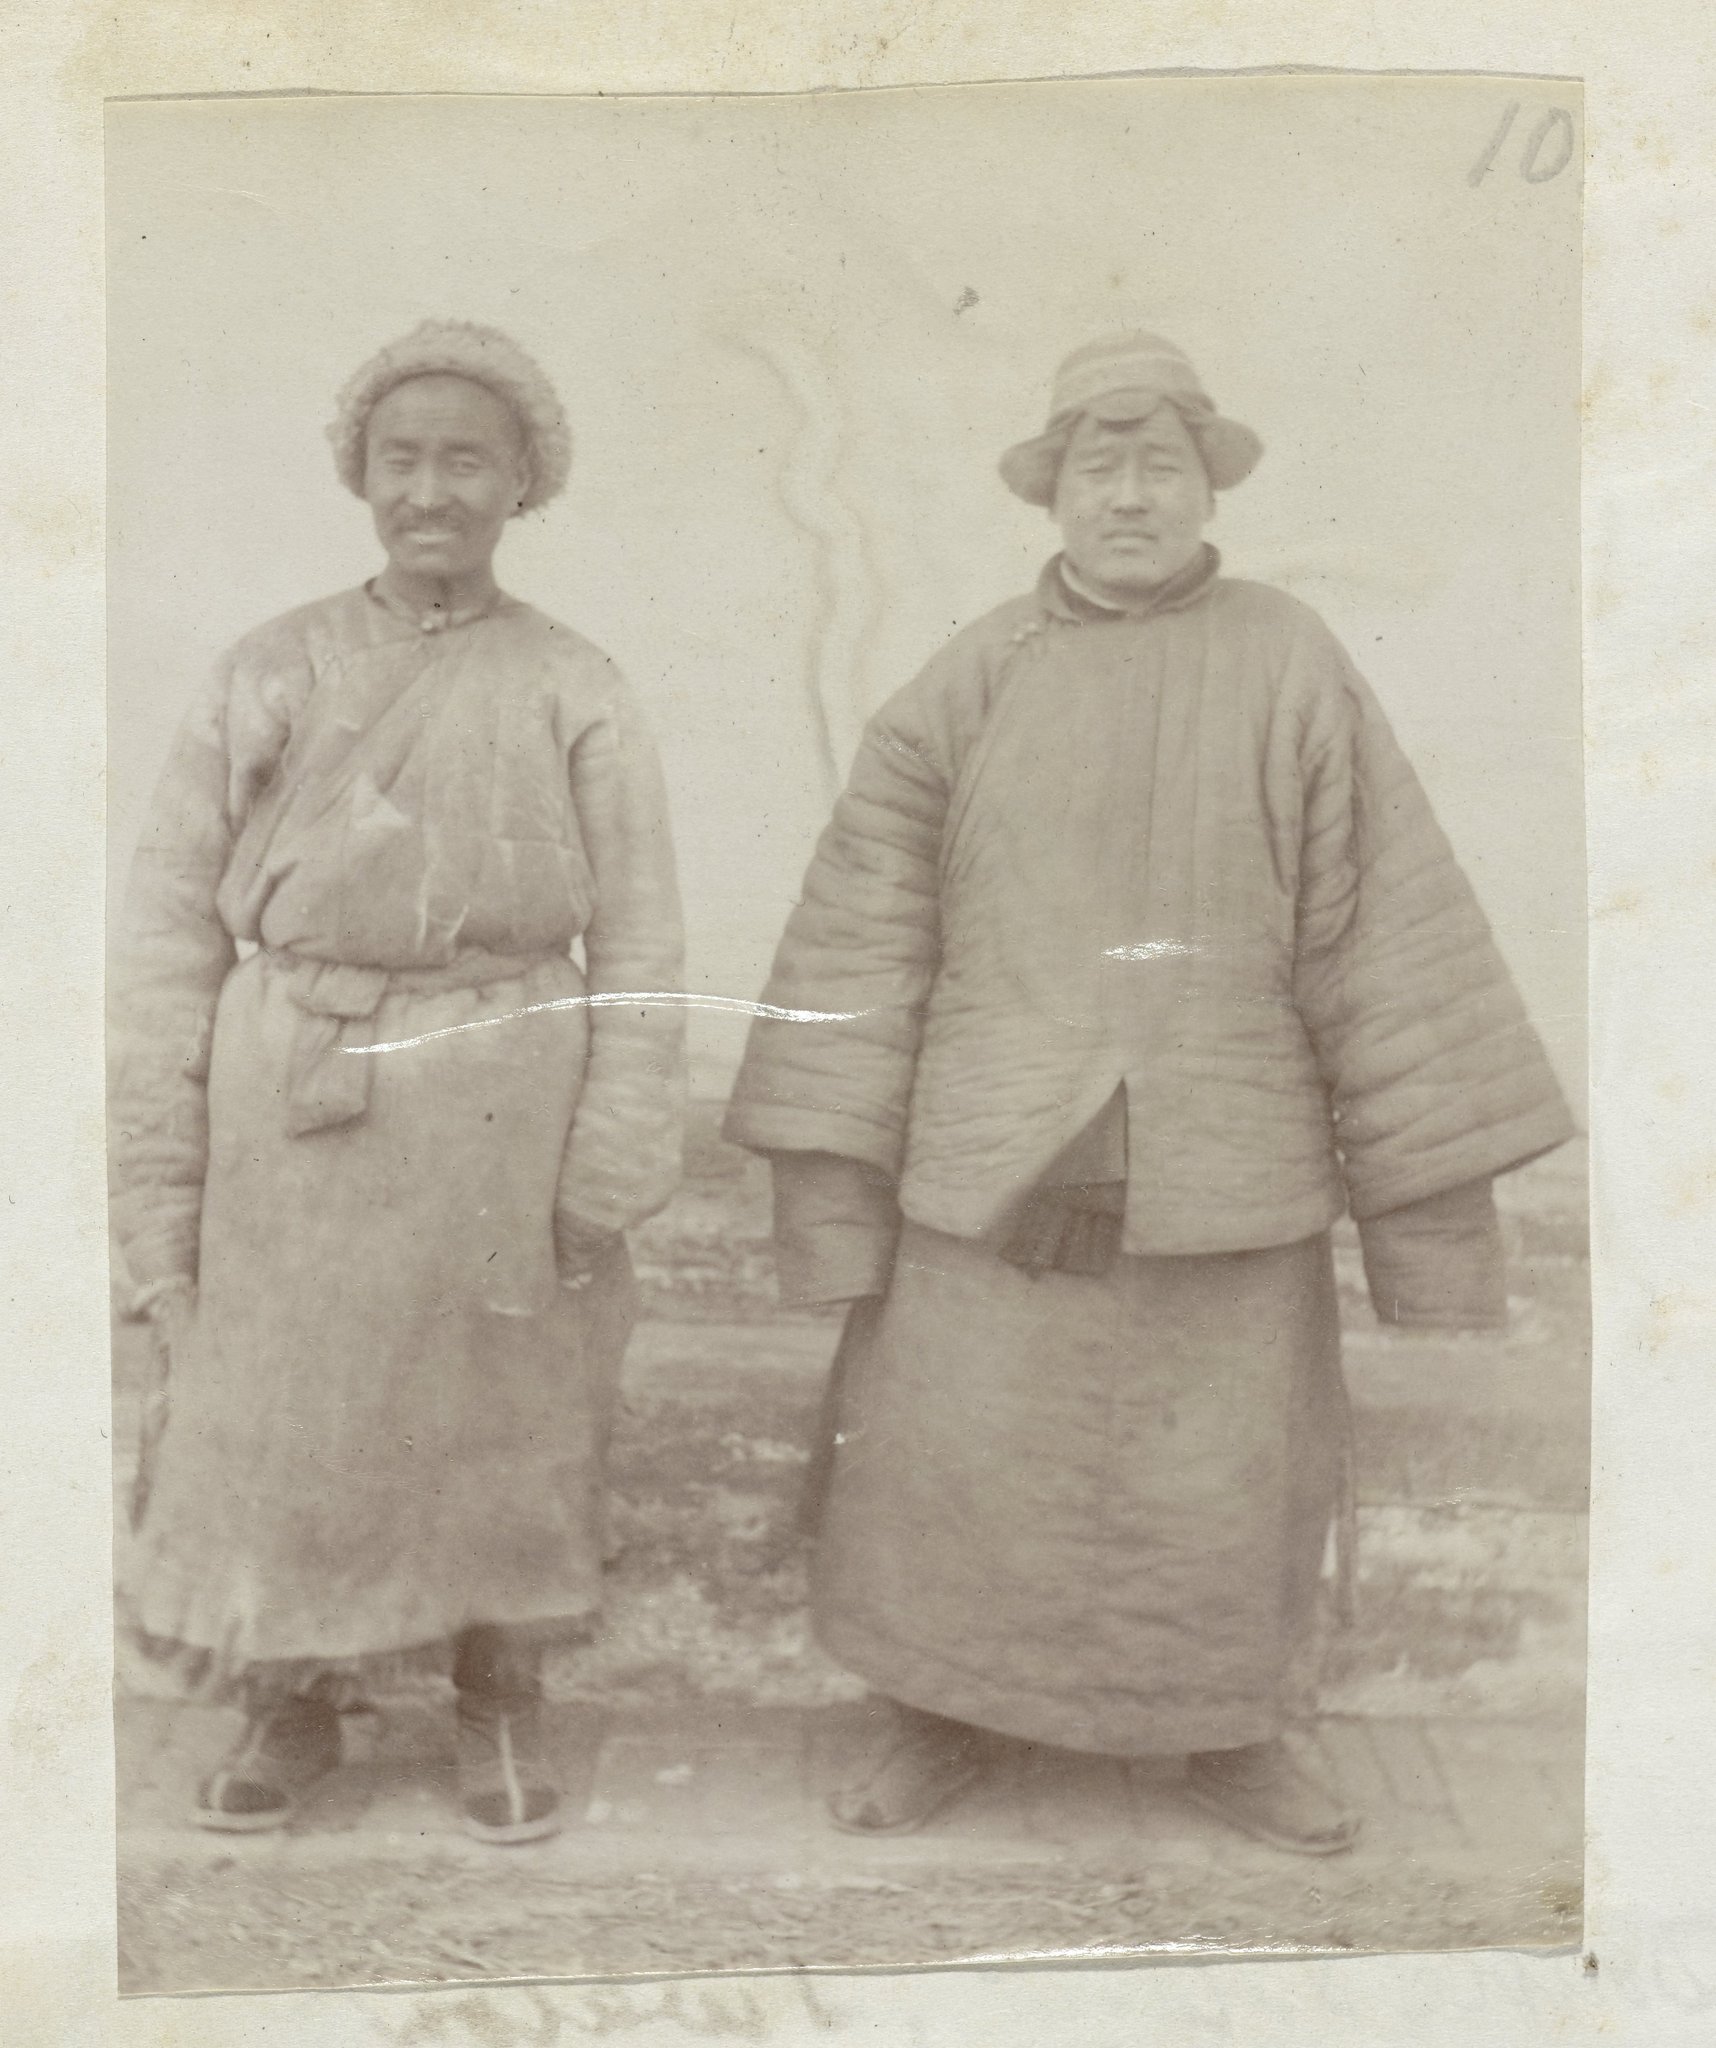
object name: album leaf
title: Portret van twee Chinese mannen in winterkleding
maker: Anonymous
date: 1879-1890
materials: paper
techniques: albumen print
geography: china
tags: coat, historical persons not known by name, china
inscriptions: inscription: ‘10’